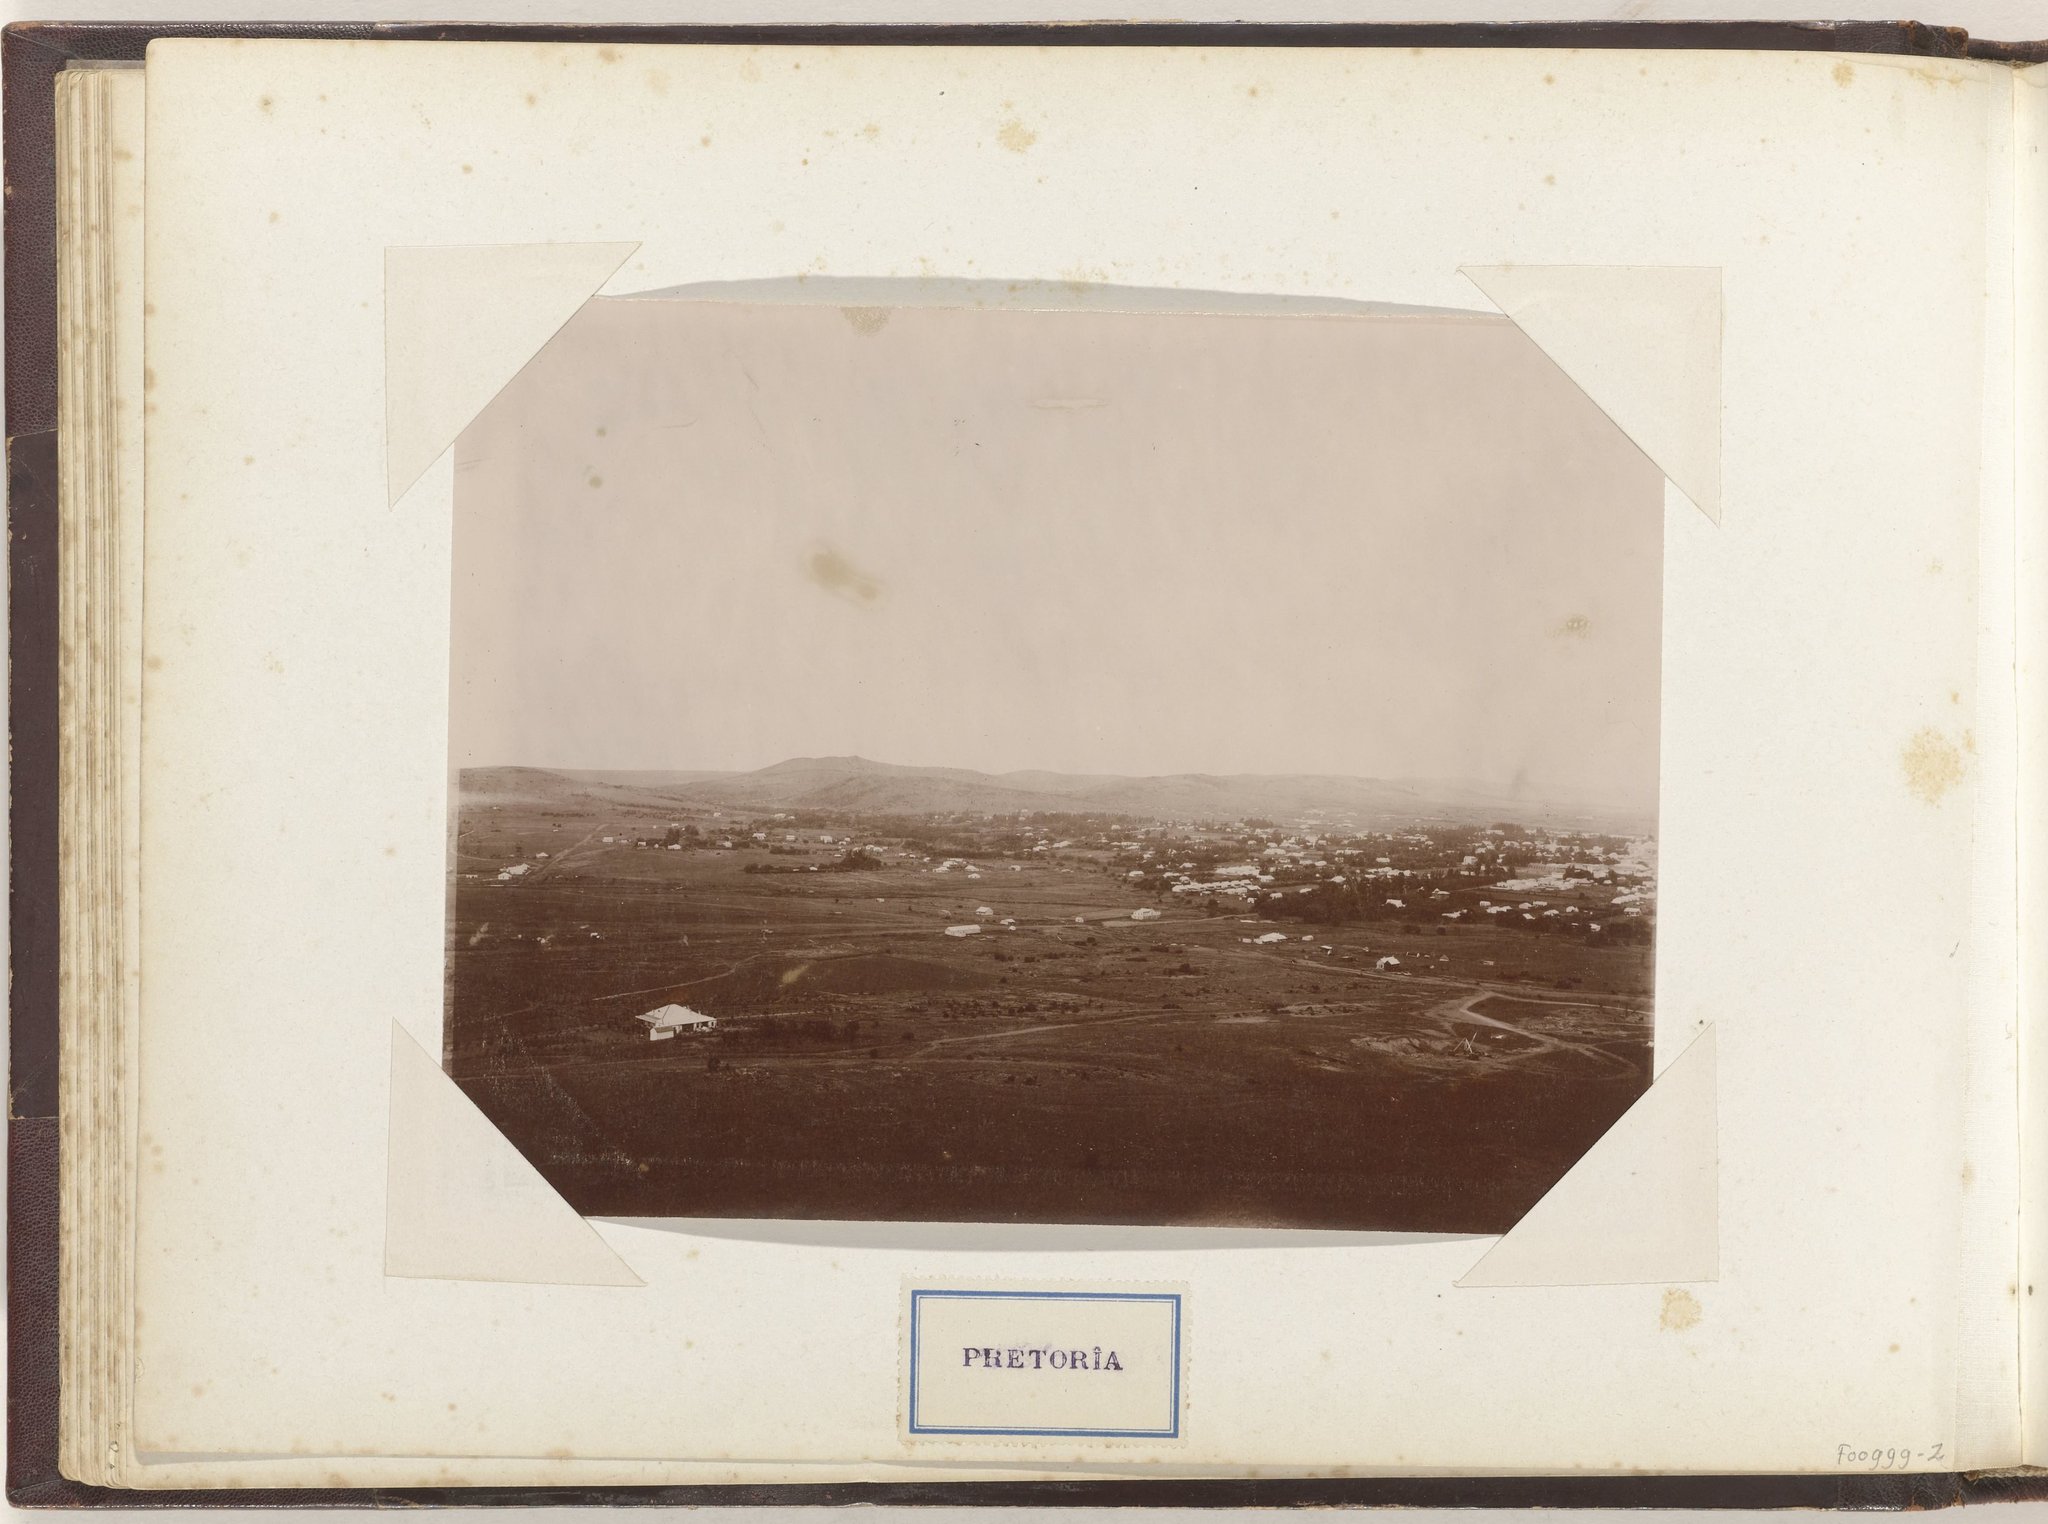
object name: photograph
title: Pretoria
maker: Anonymous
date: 1885-1910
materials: paper, photographic support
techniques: collodion silver print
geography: pretoria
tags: prospect of city, town panorama, silhouette of city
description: Onderdeel van Album met 191 foto's van een reis naar en door Zuid-Afrika.